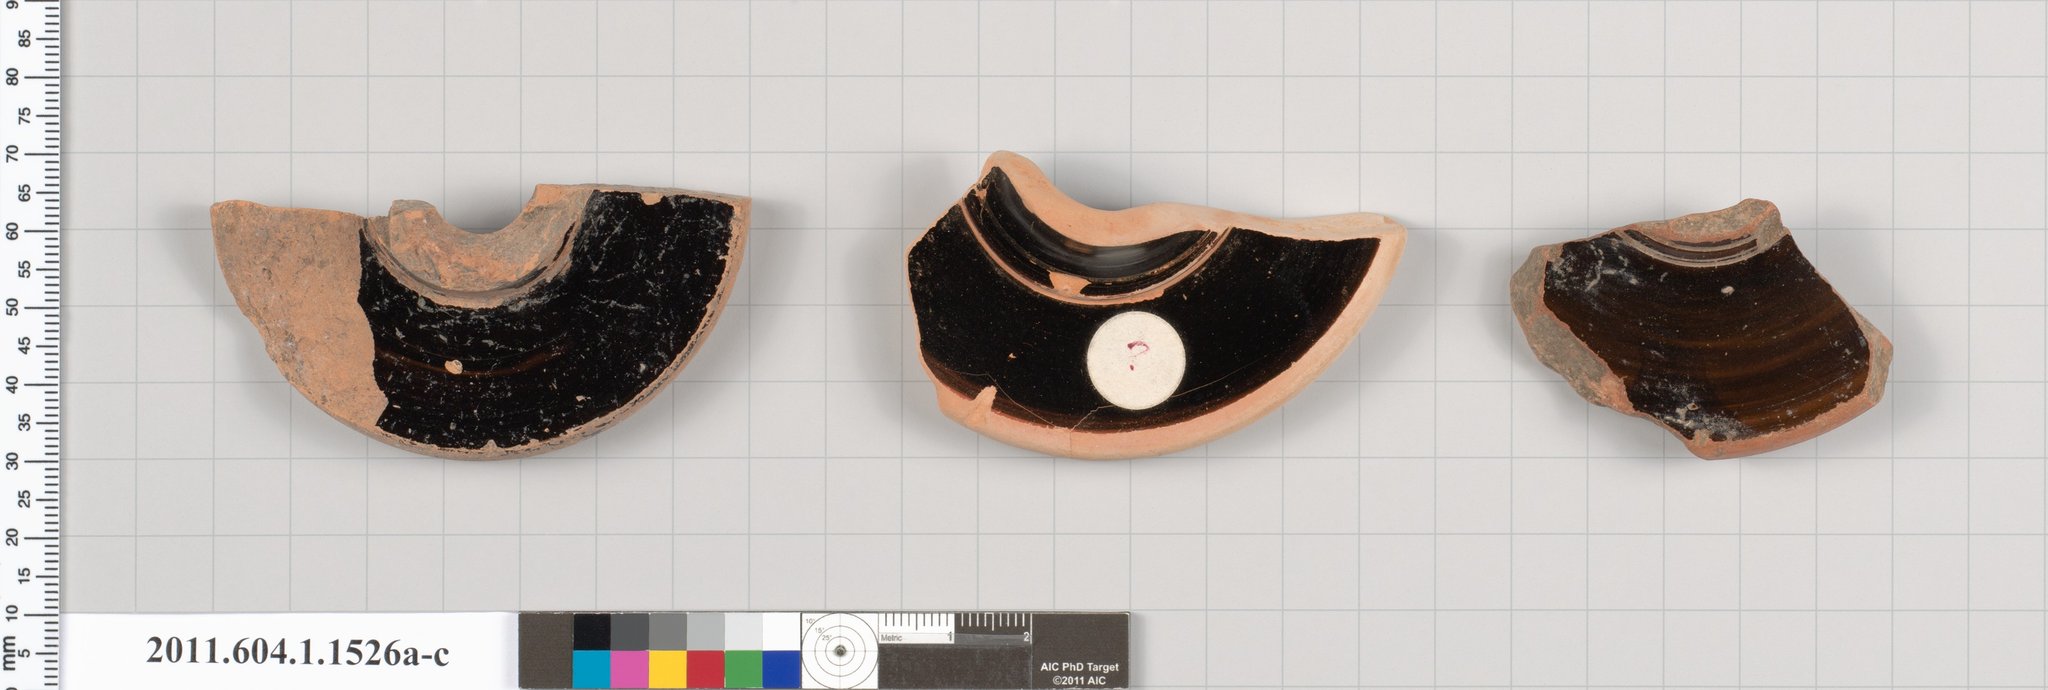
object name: kylix fragment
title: Terracotta fragments of kylikes (drinking cups)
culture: greek, attic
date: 500-401 BCE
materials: terracotta